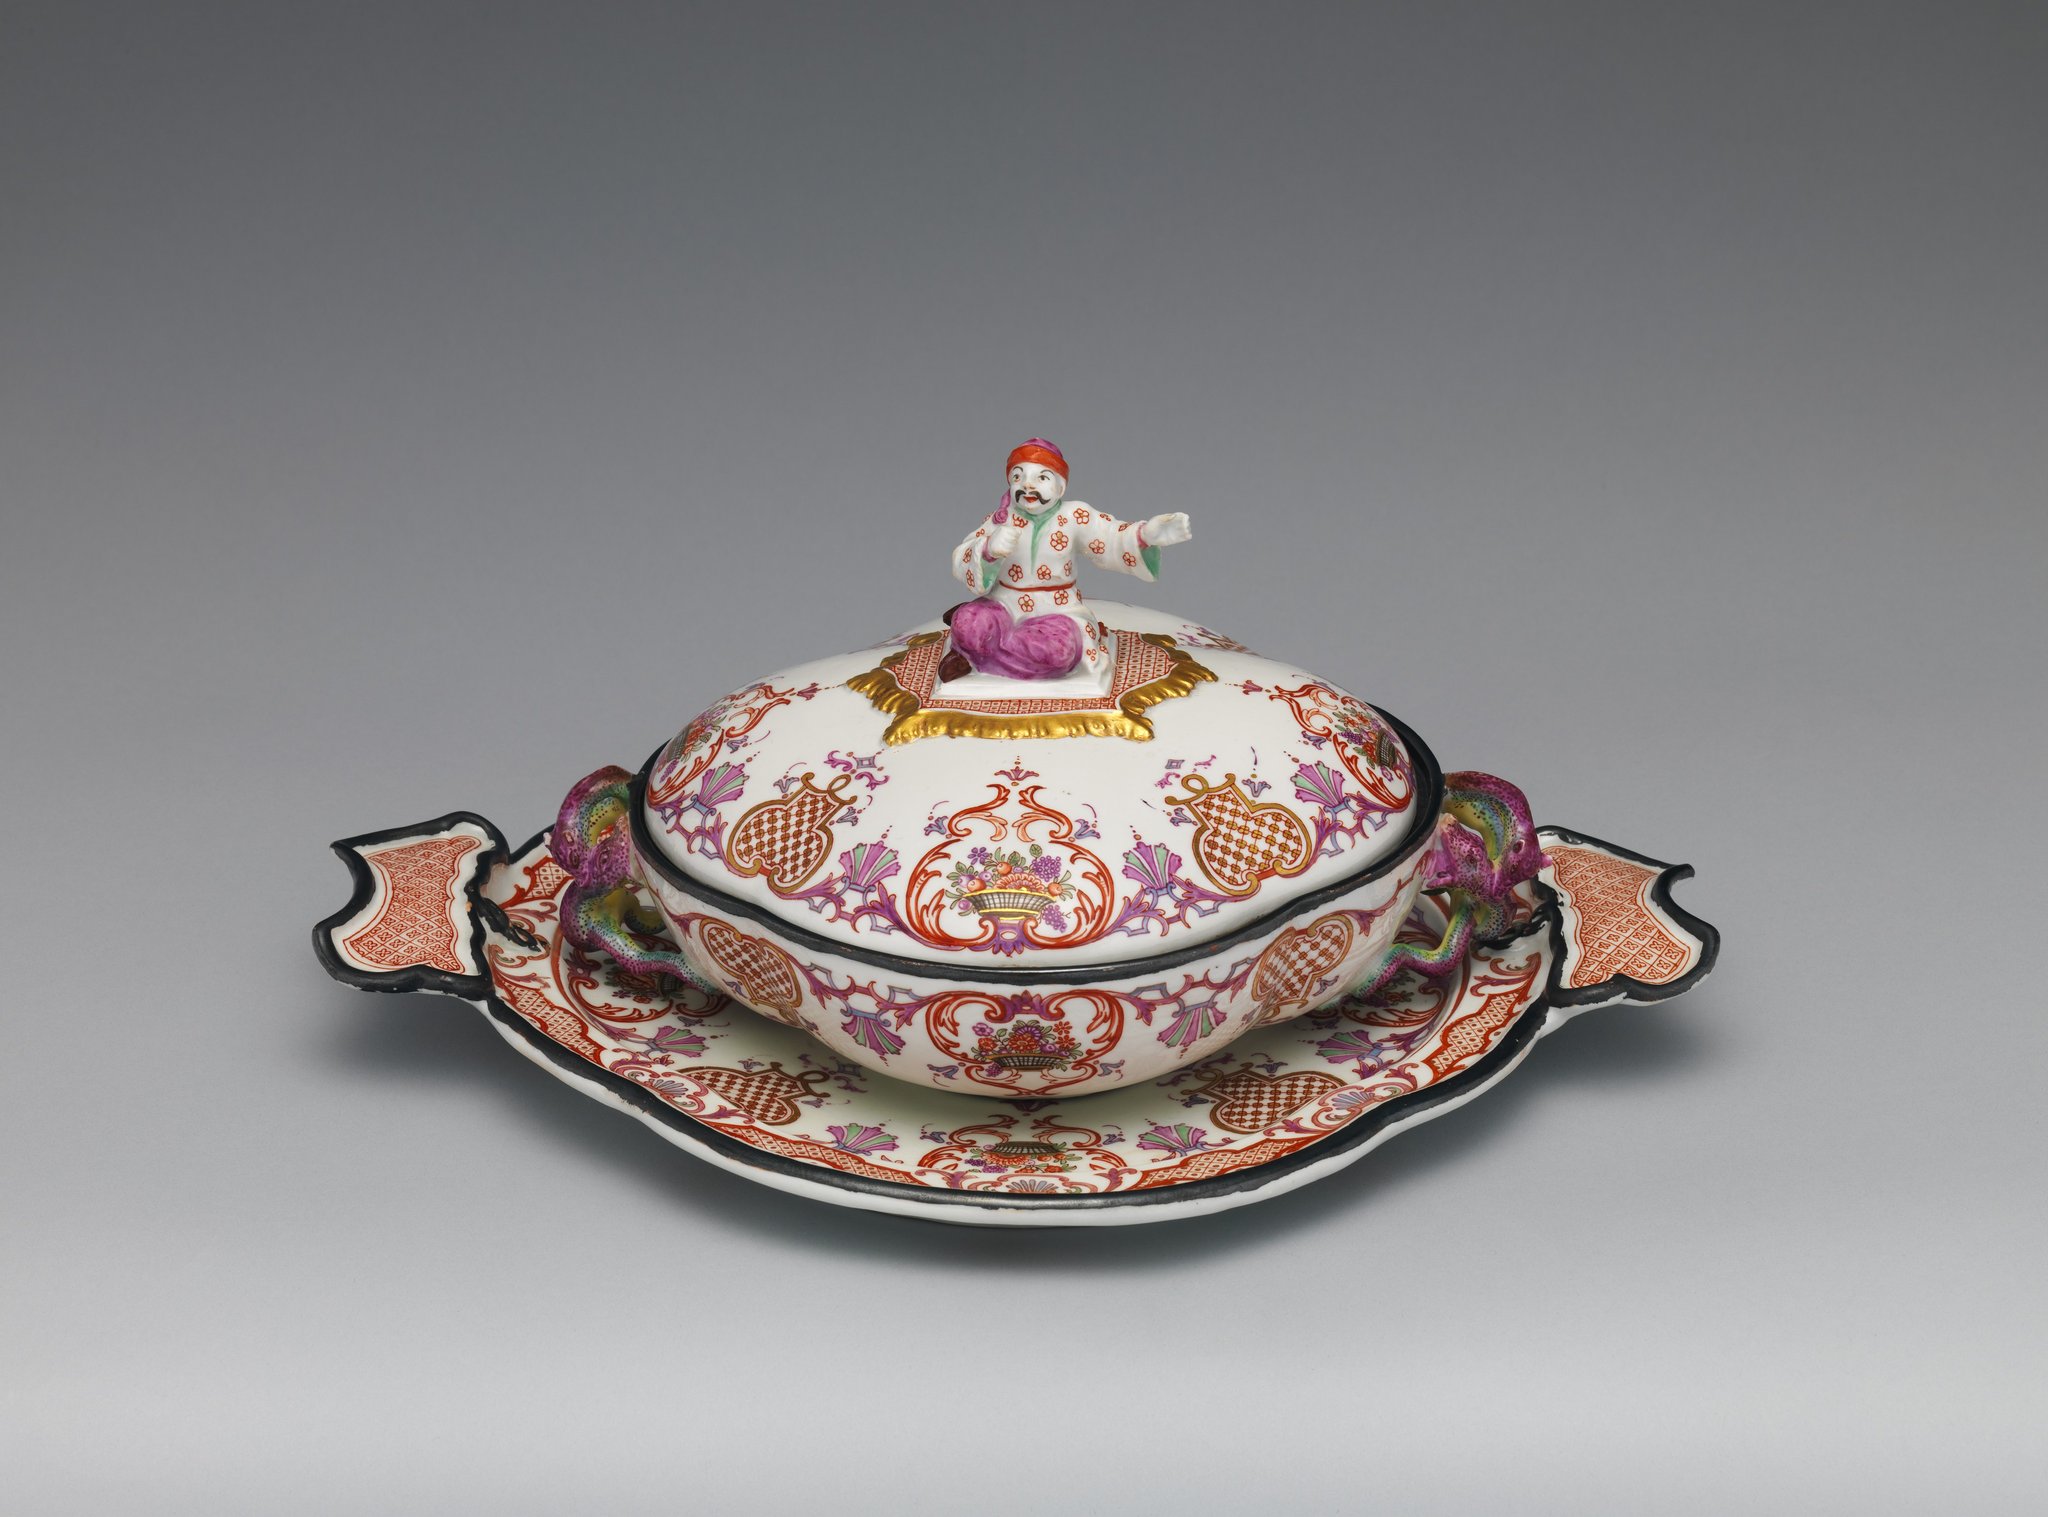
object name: tureen and stand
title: Small tureen and stand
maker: vienna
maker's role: manufactory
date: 1730-1735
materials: hard paste porcelain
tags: men